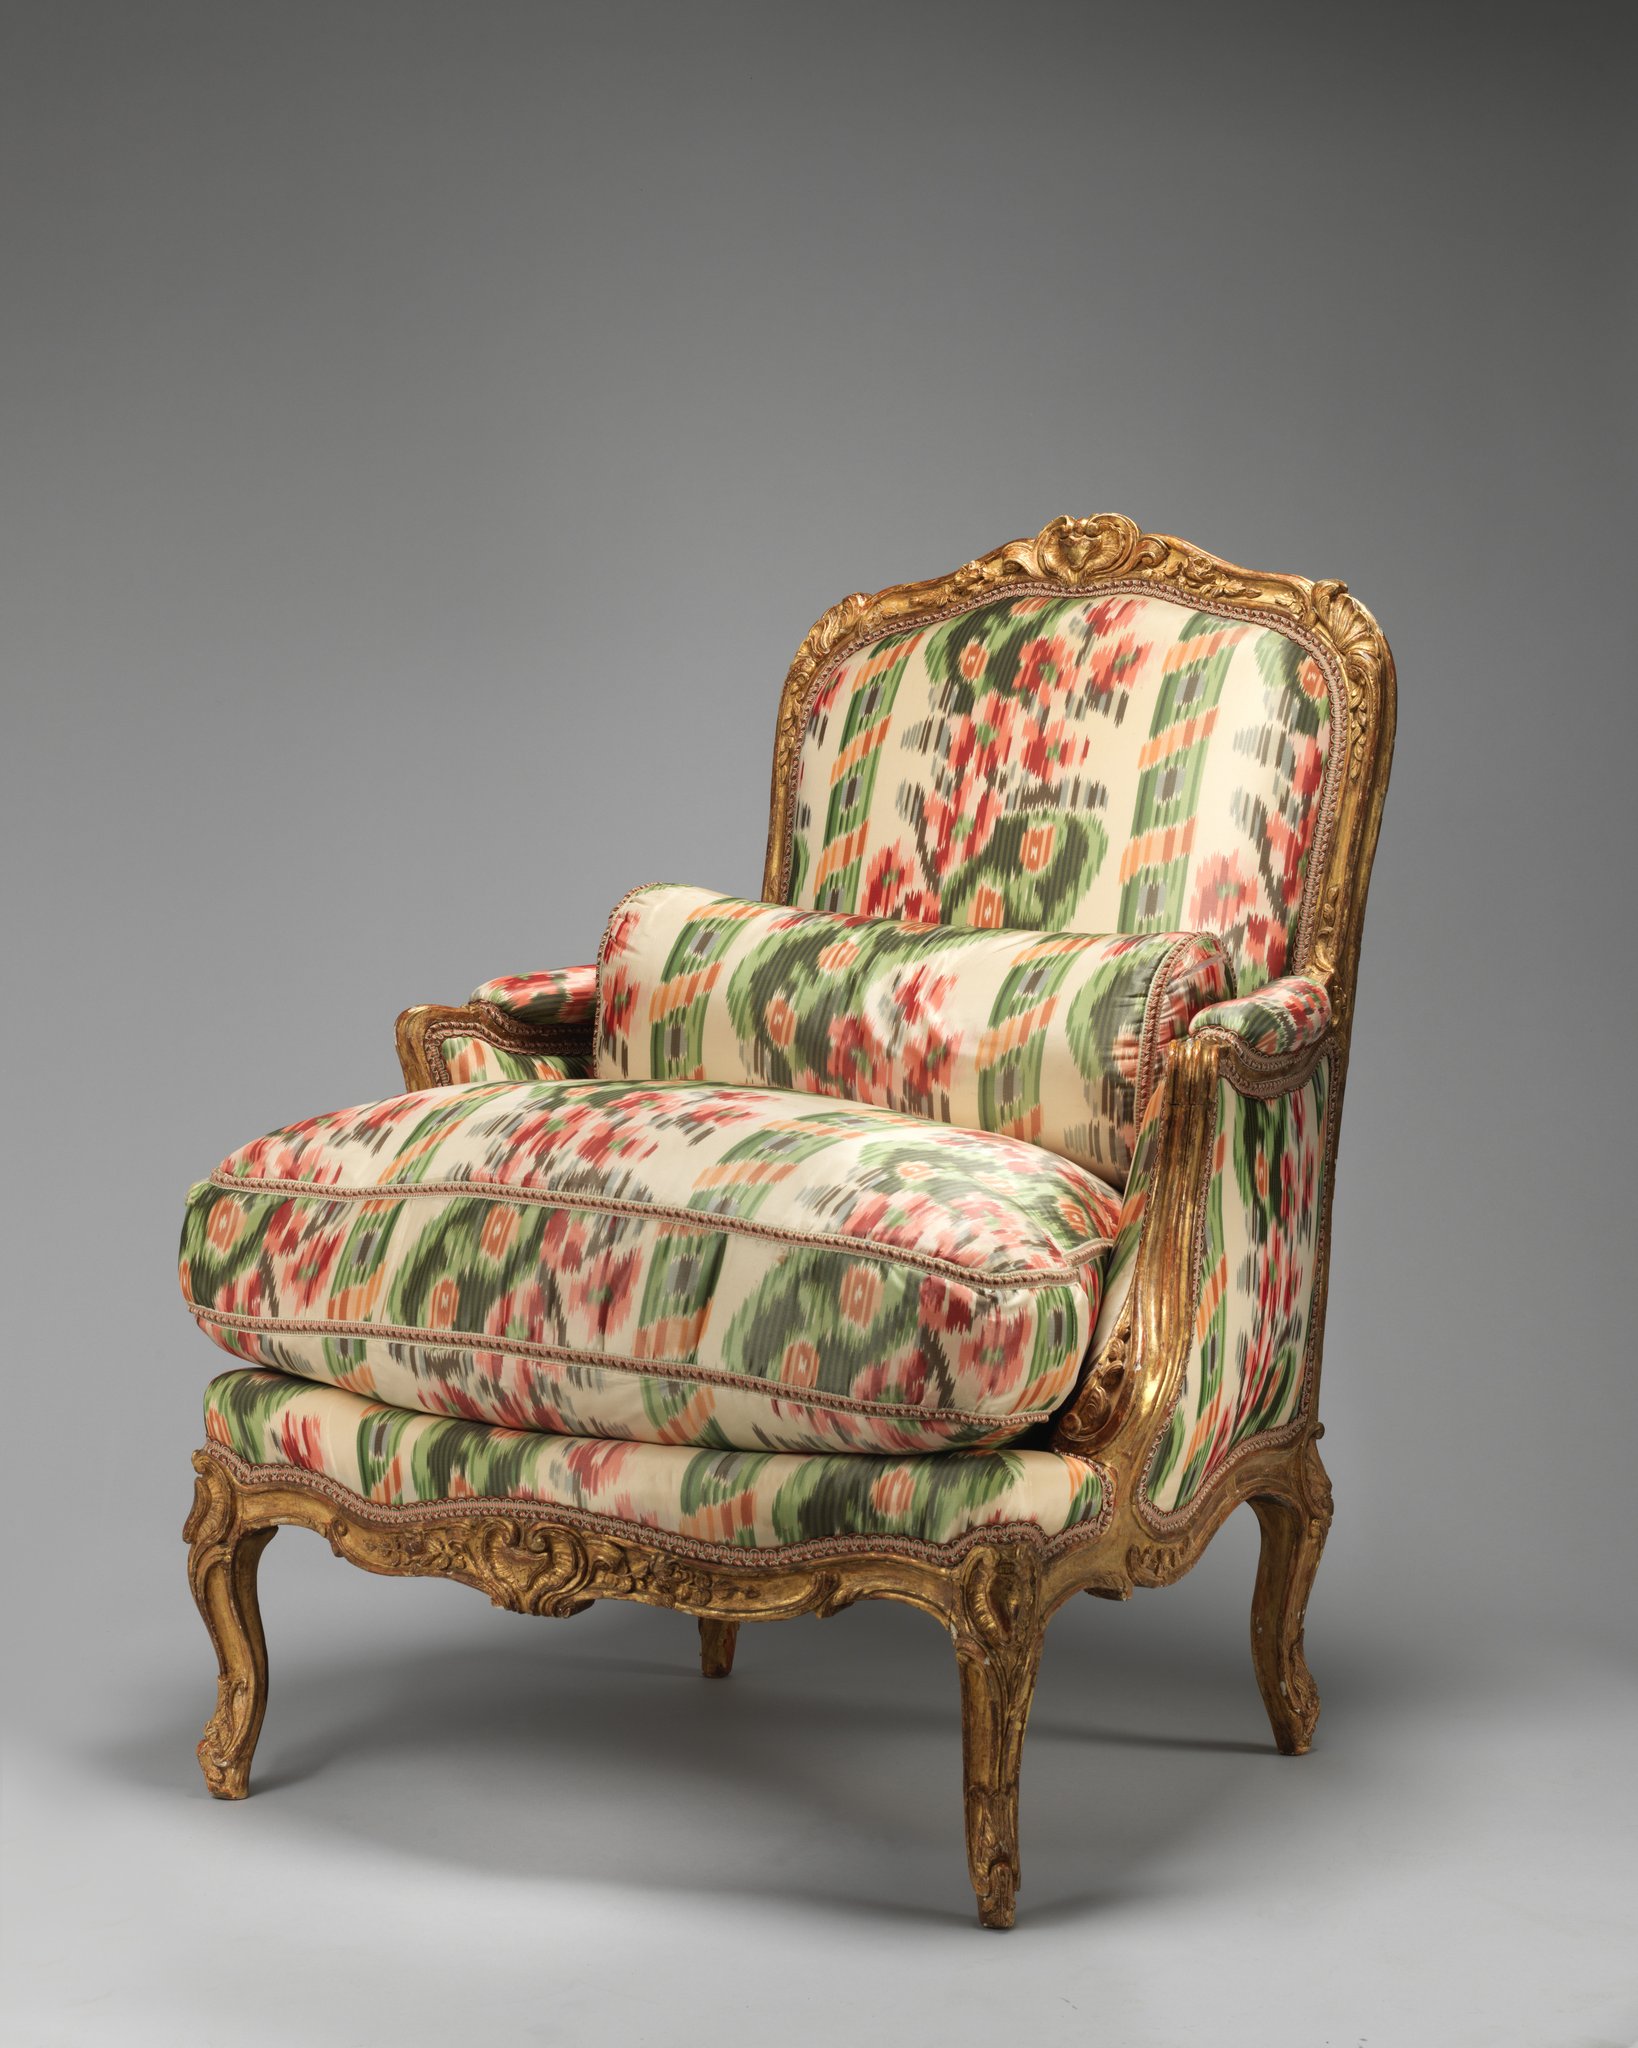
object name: armchair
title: Armchair (bergère à la Reine) (one of a pair)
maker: jean-baptiste i tilliard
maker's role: maker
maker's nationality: french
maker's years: 1686-1766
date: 1701-1800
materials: wood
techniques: carving, gilding